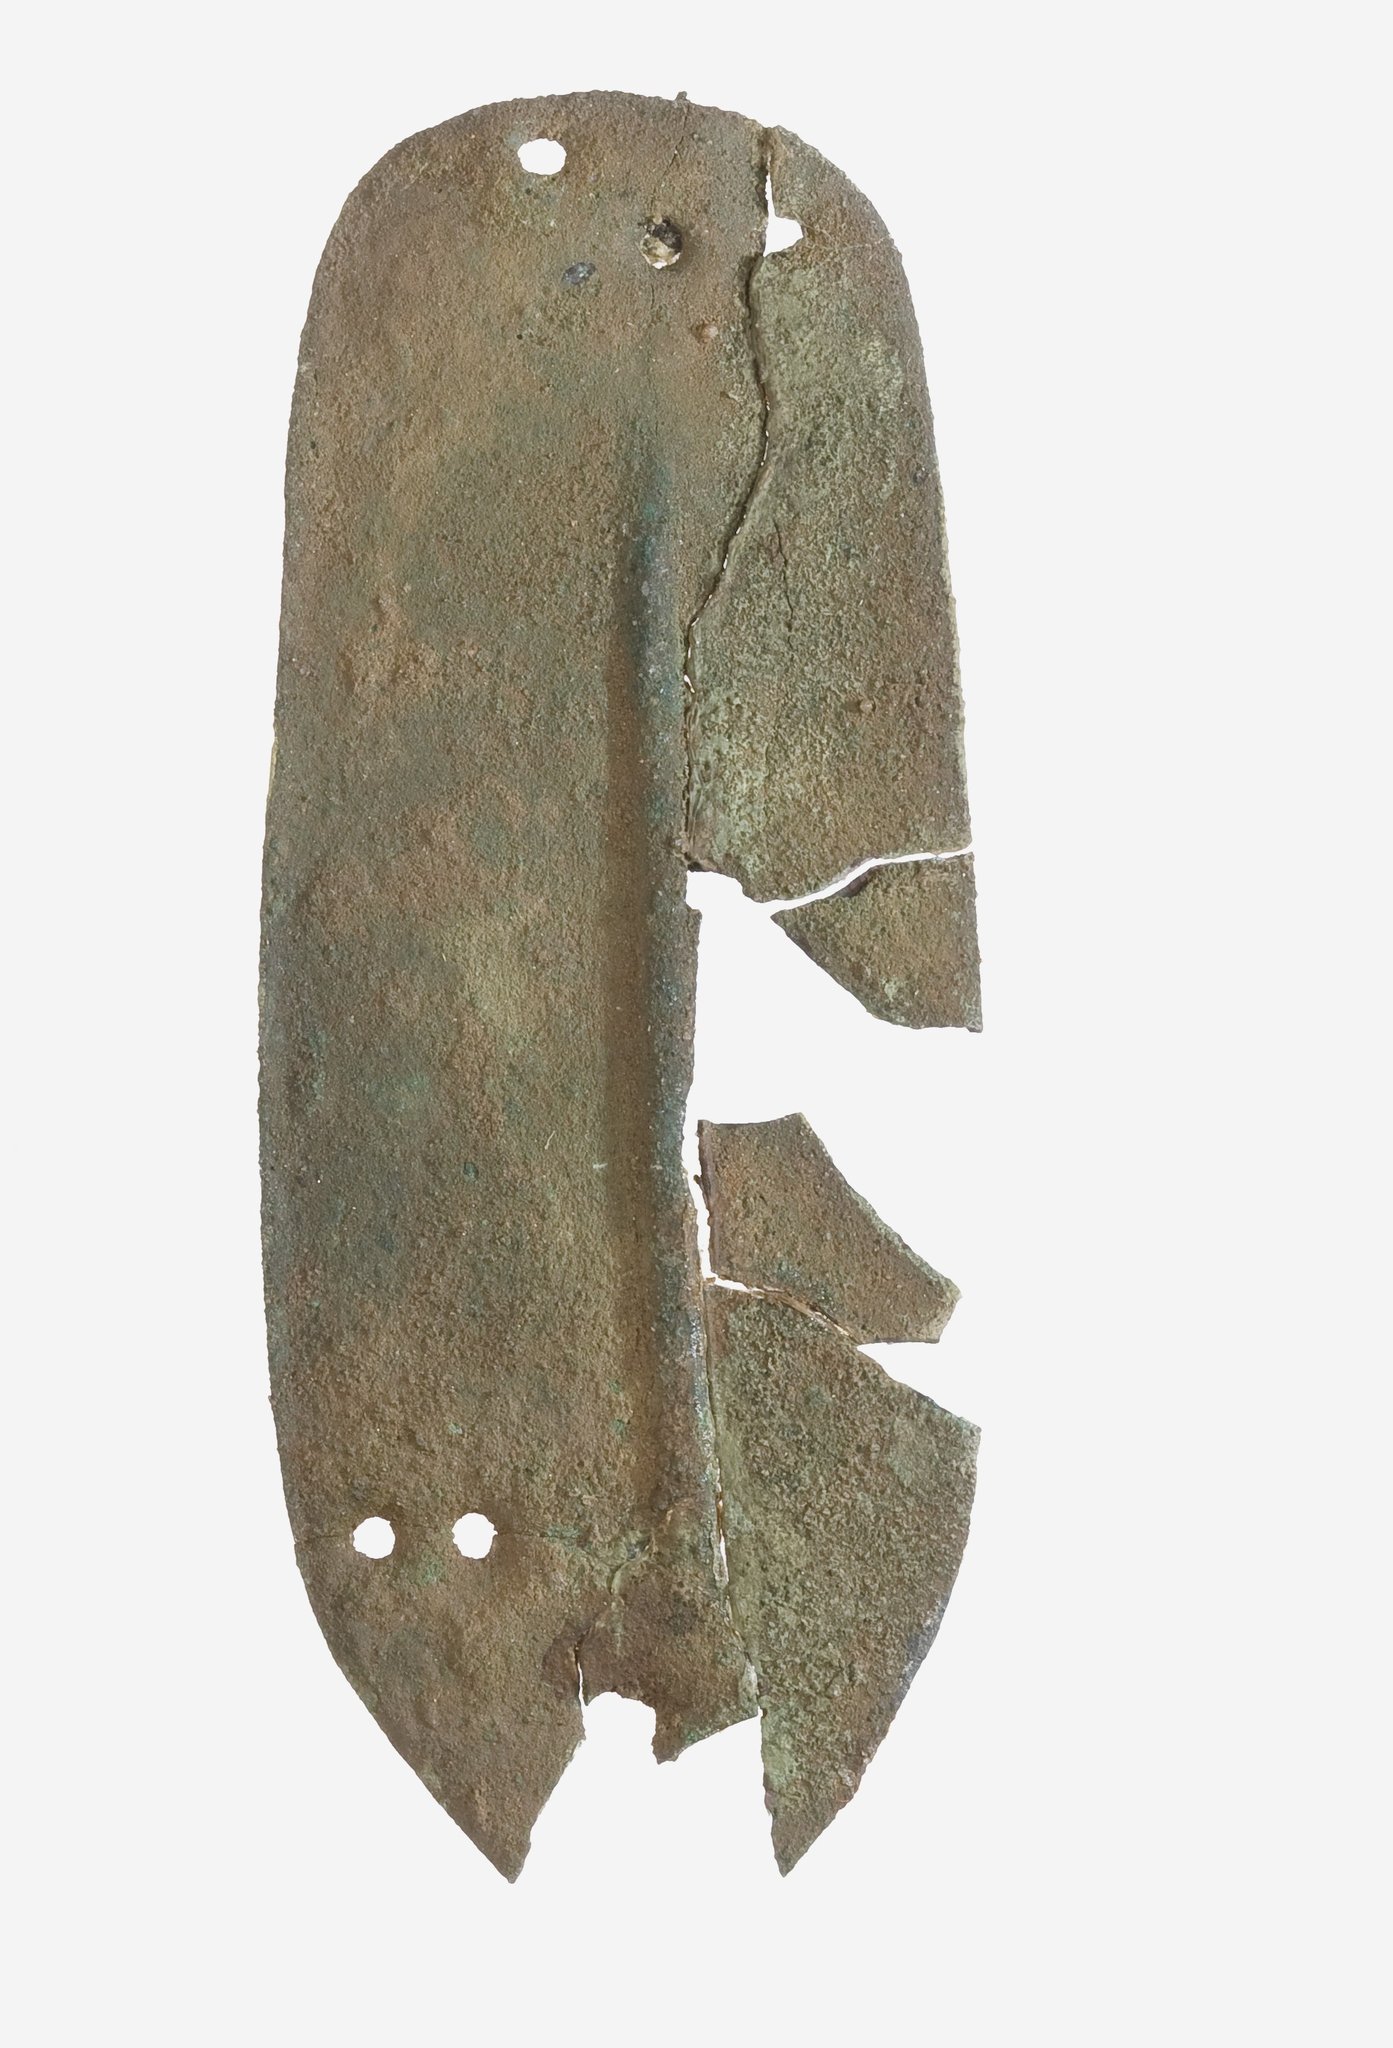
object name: armor scale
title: Scale from Armor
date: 1390-1352 BCE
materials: bronze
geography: egypt